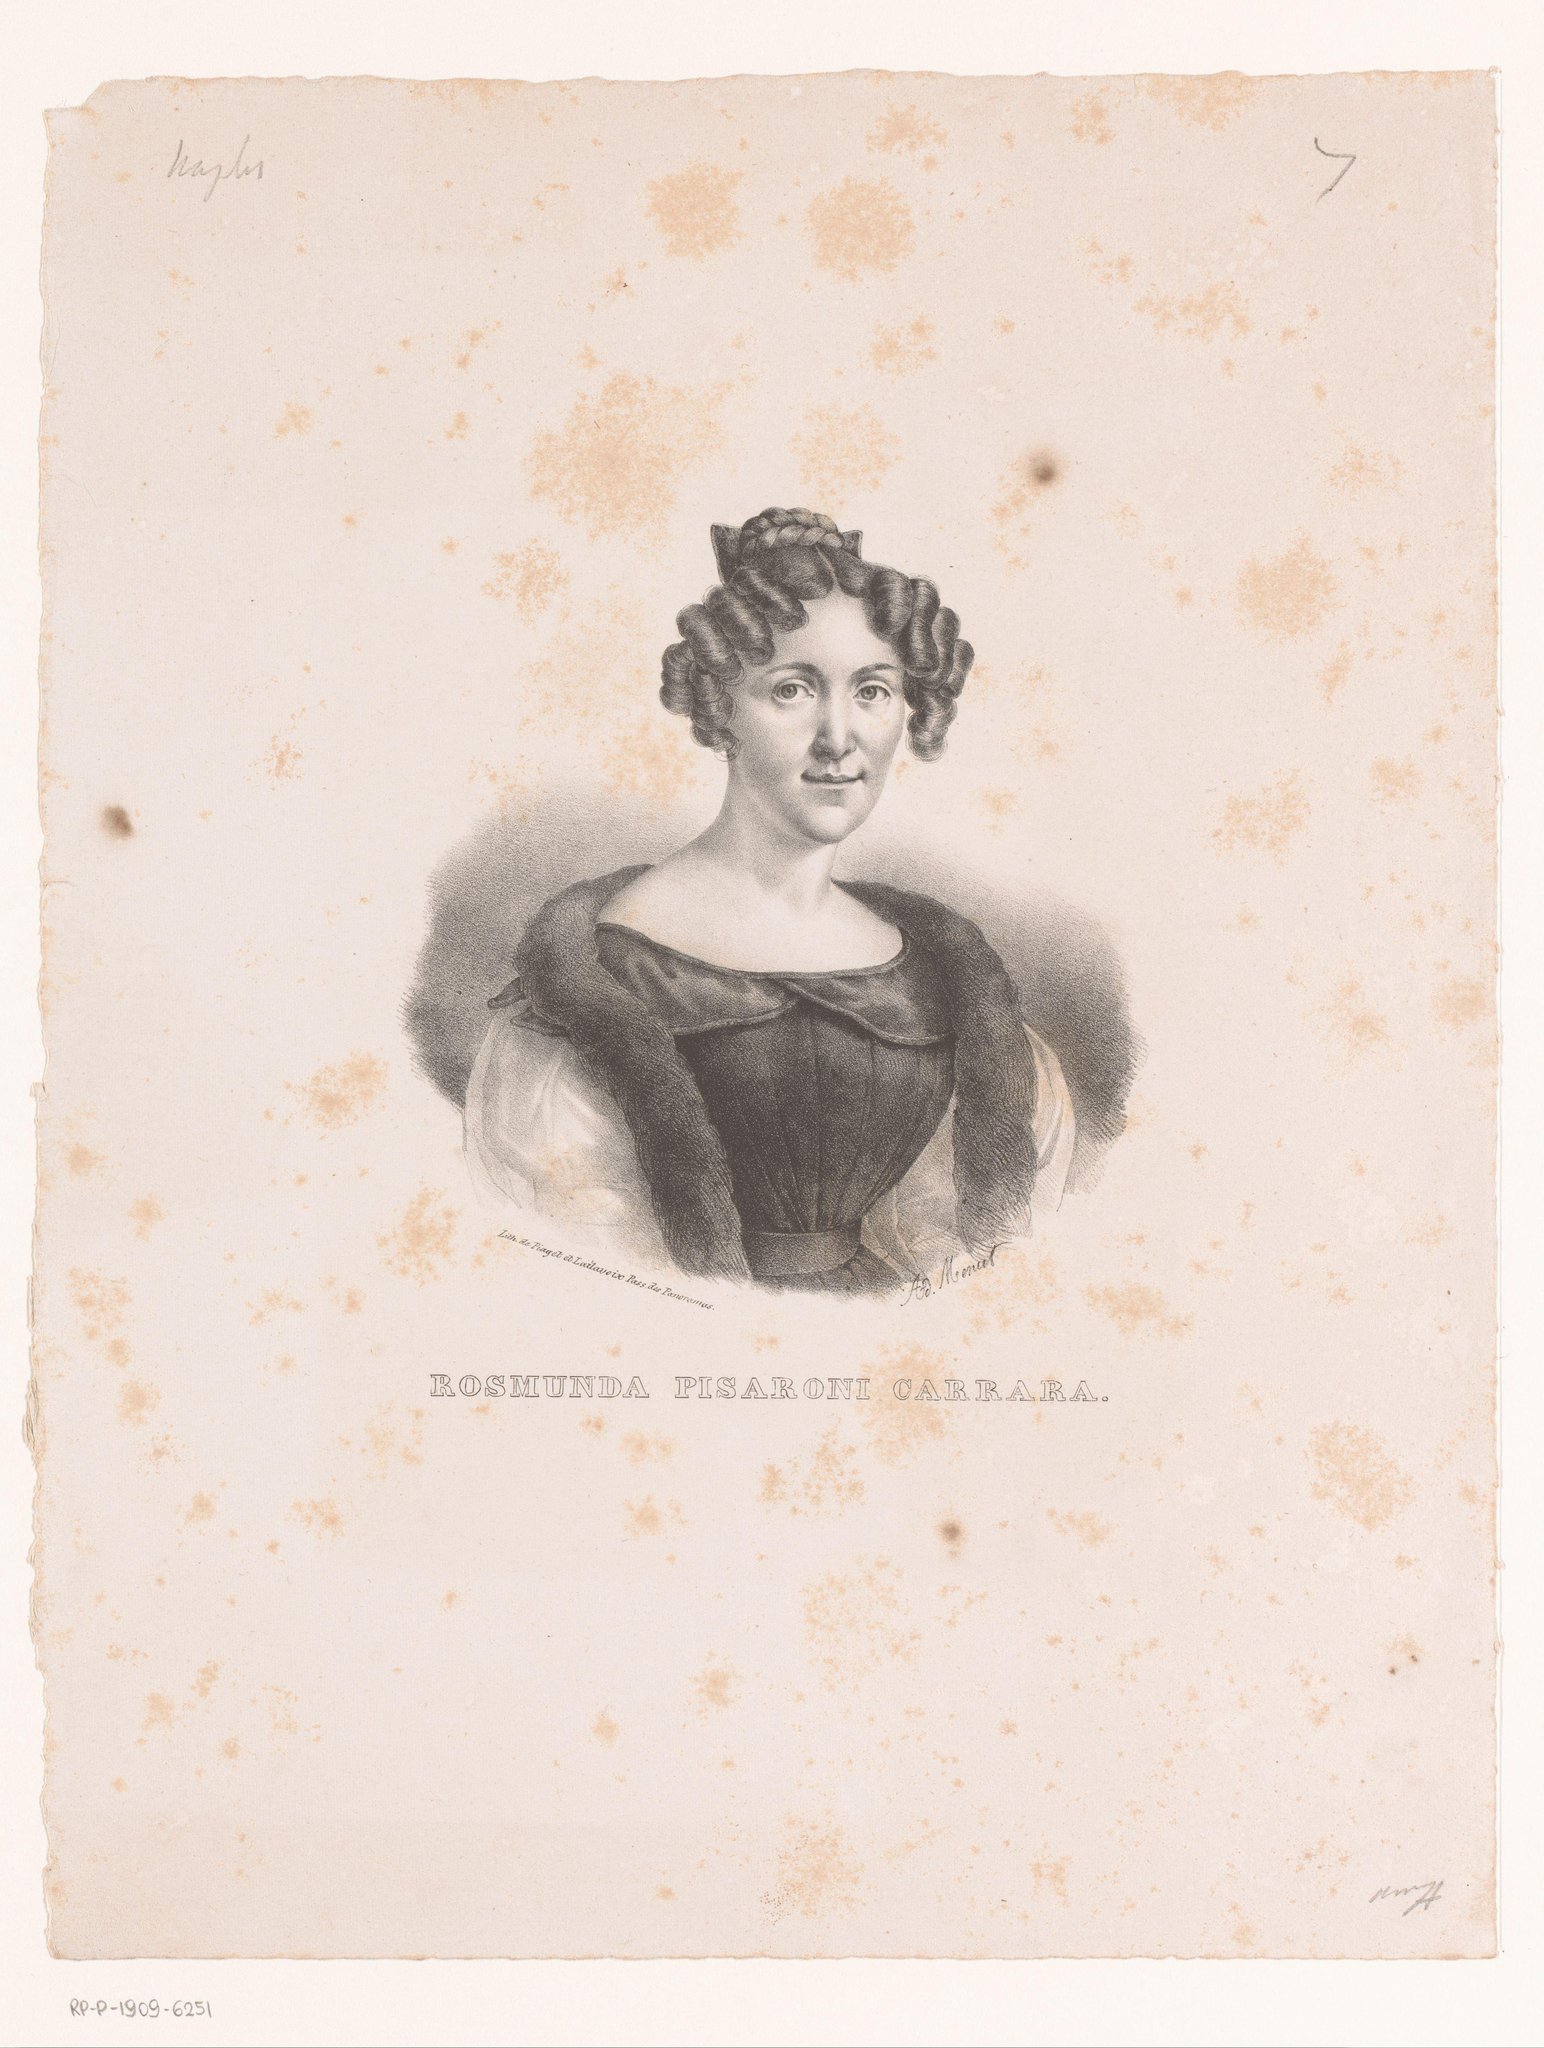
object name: print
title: Portret van Benedetta Rosmunda Pisaroni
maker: marie alexandre alophe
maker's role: print maker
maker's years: 1811-1883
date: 1827-1883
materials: paper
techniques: lithograph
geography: paris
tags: historical persons, opera-singer (female)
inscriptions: collector's mark: Lugt 2228